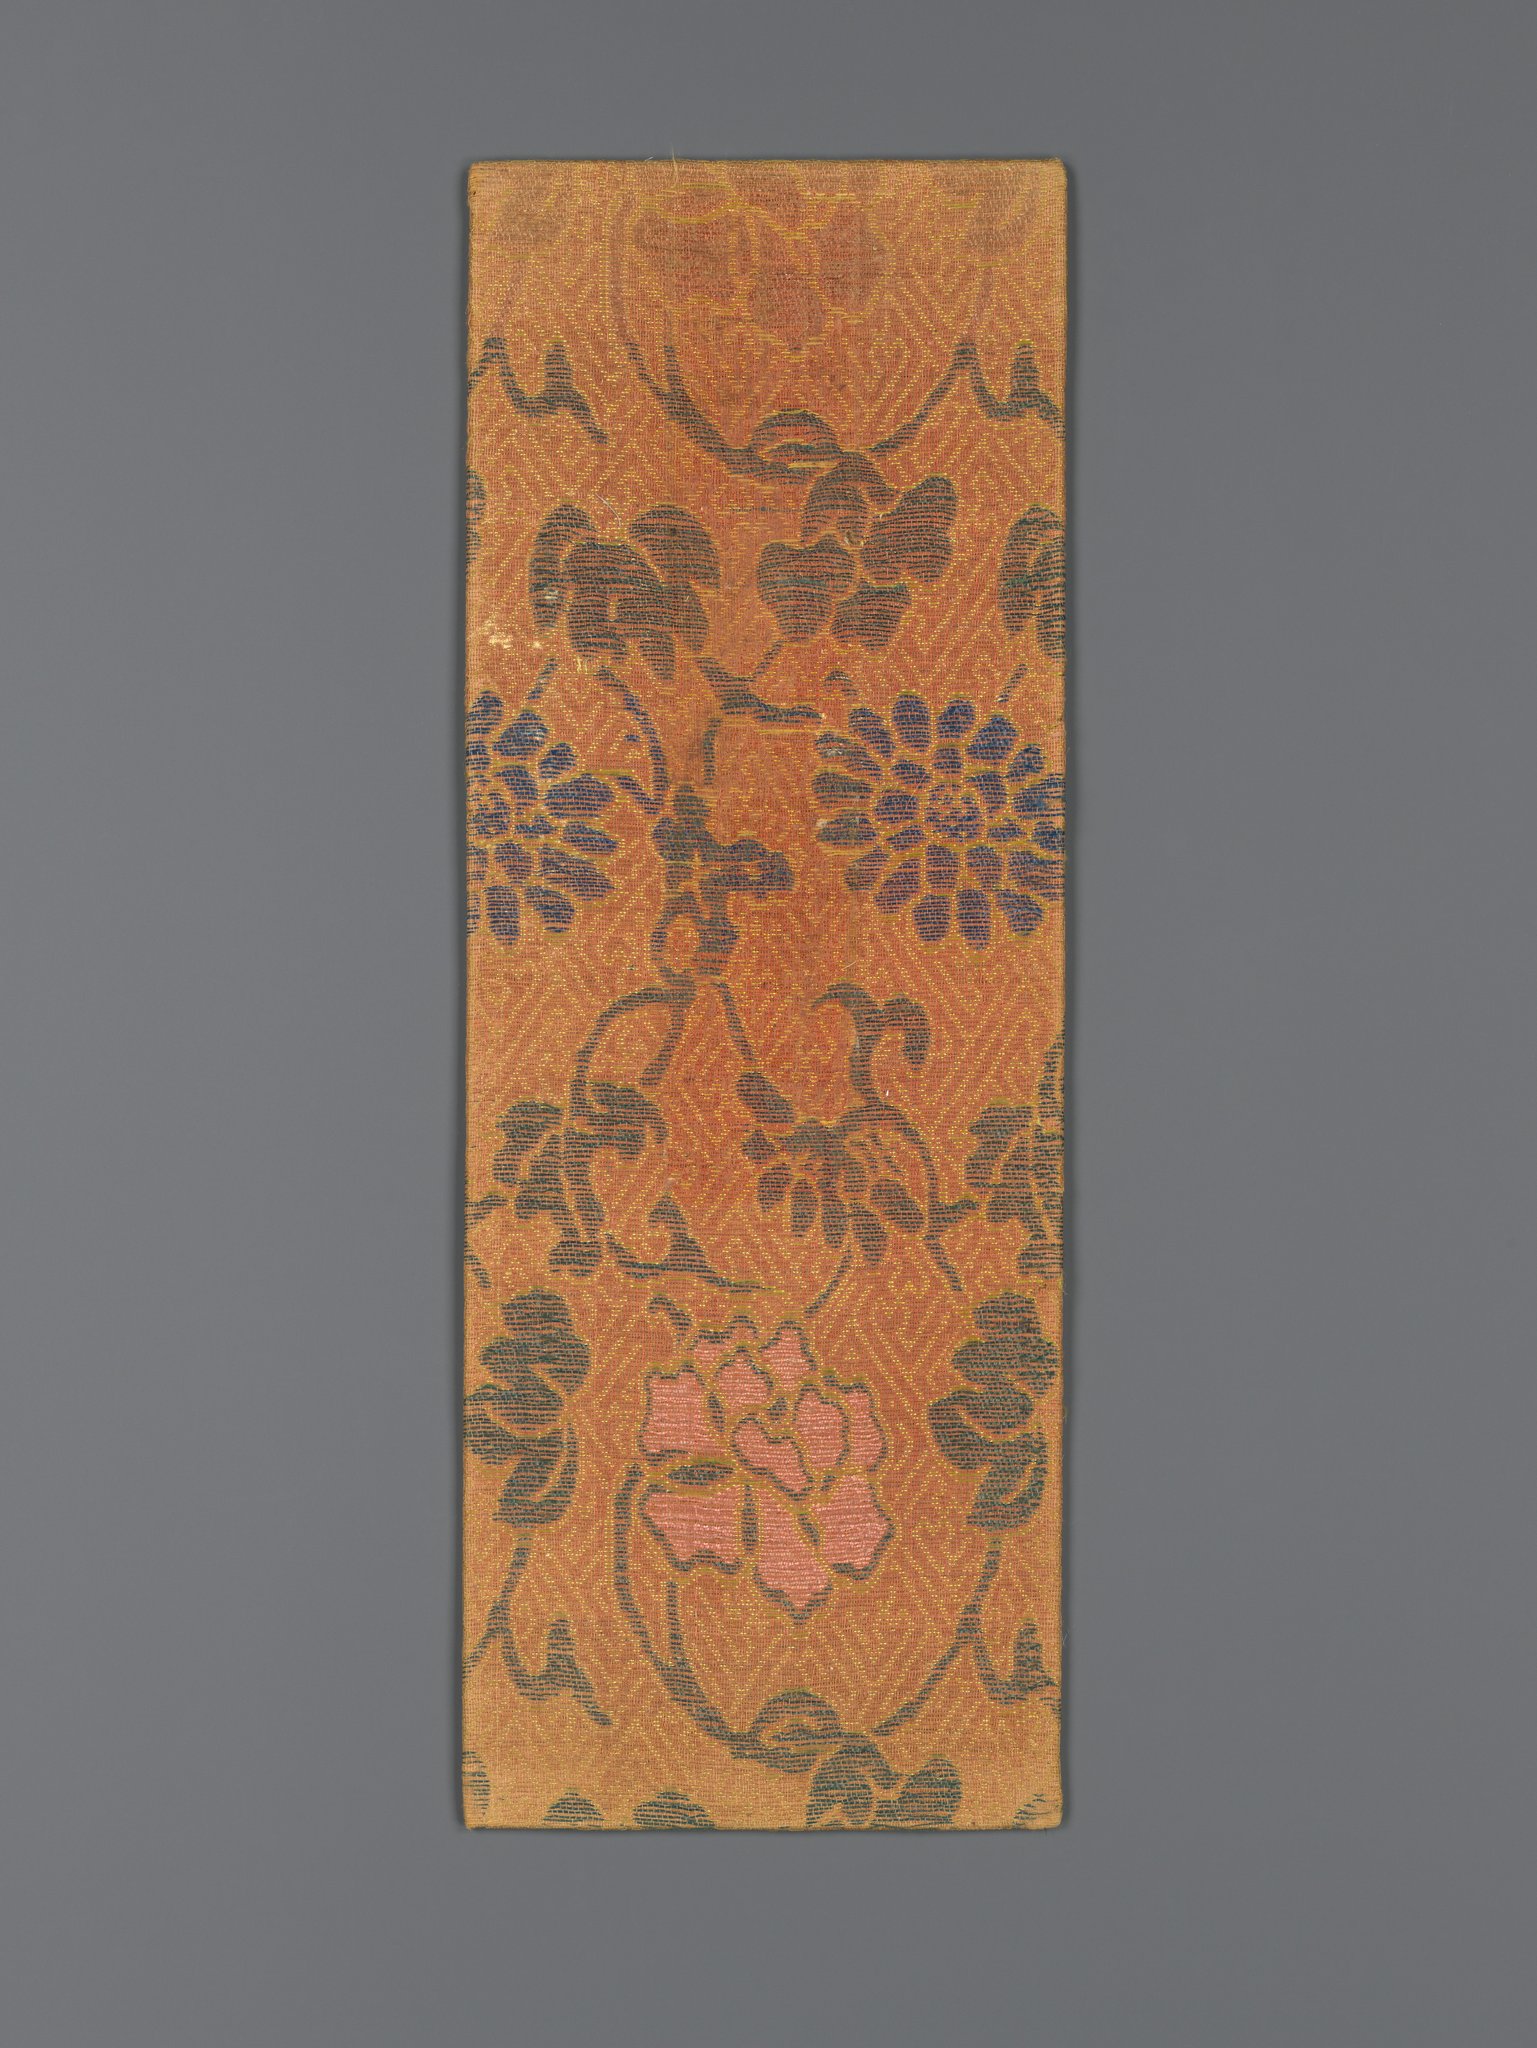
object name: sutra cover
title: Sutra Cover with Various Flowers and Leaves with Scrolling Stems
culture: chinese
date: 1501-1600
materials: silk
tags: flowers,leaves